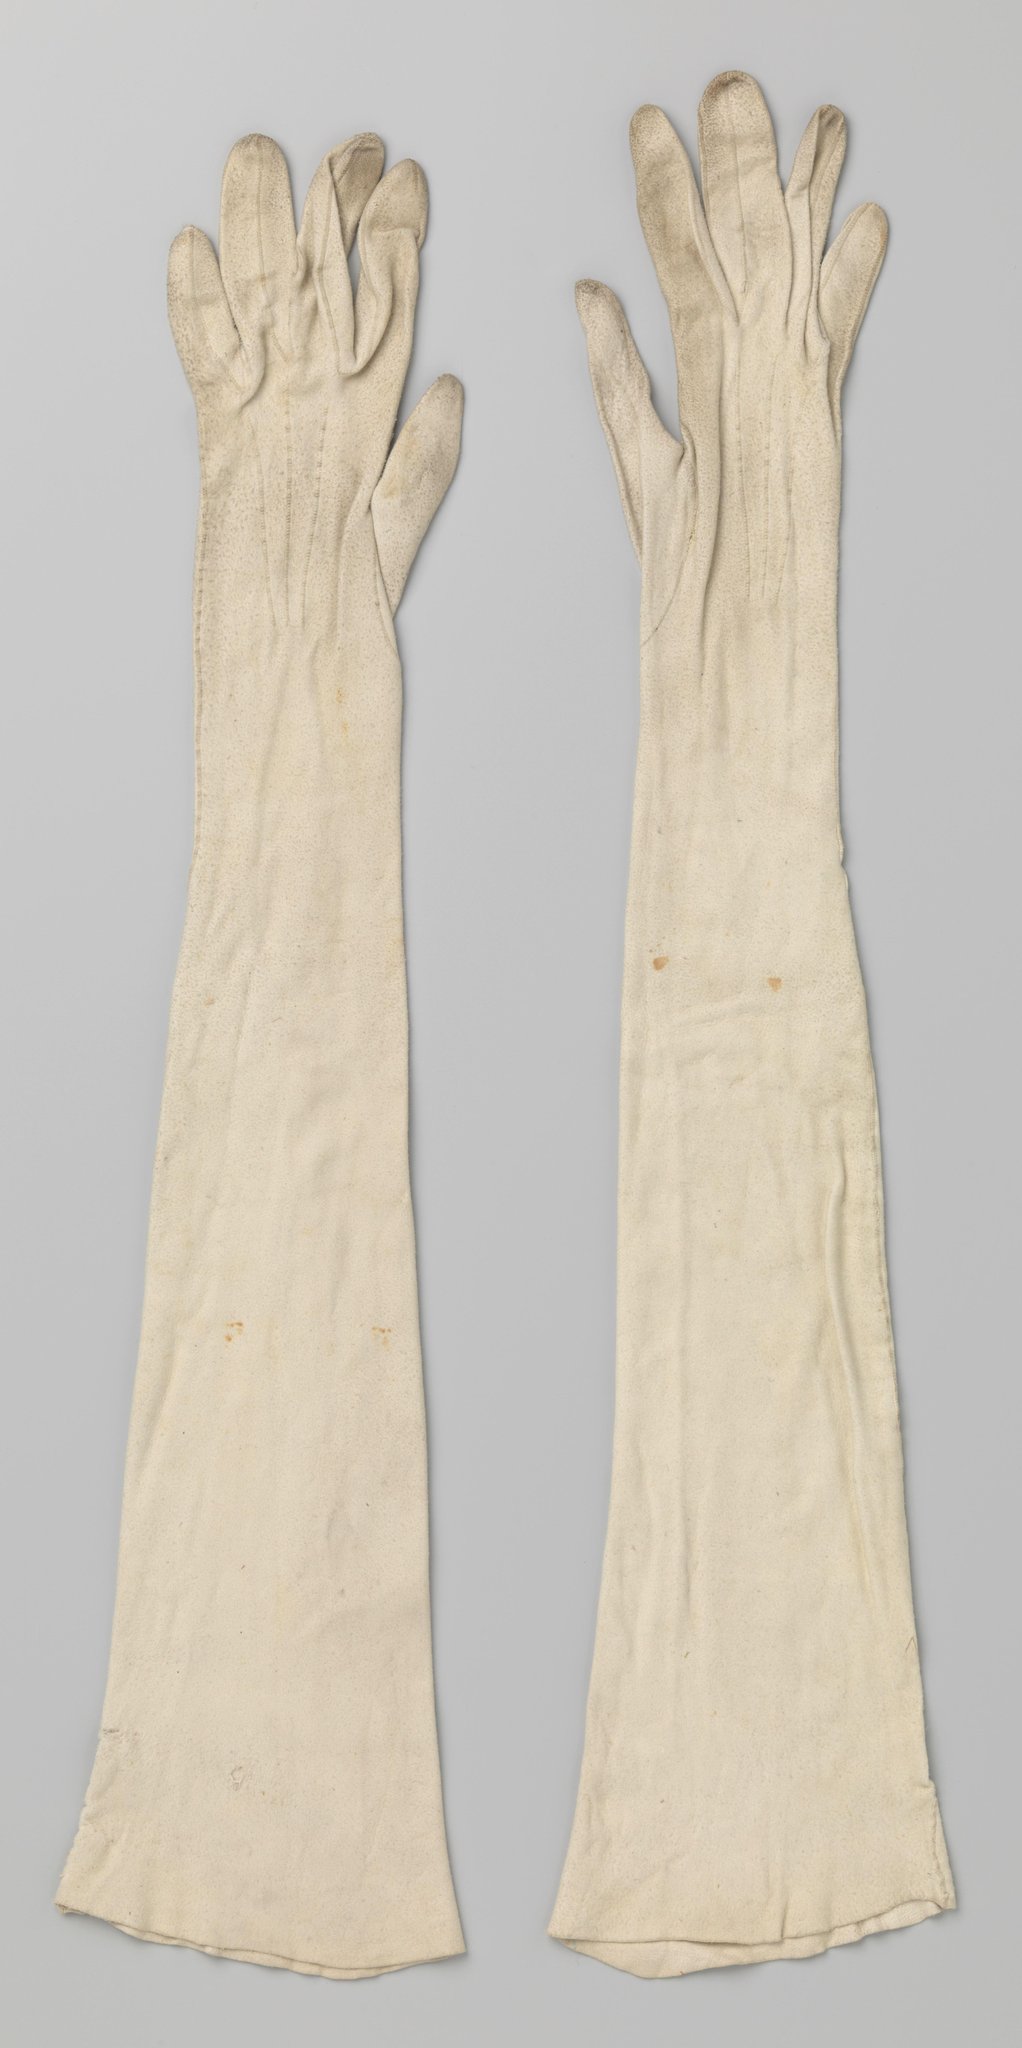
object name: clothing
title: Handschoen van wit zeemleer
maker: Anonymous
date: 1915-1925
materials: leather, mother of pearl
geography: france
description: Rechterhandschoen van wit zeemleer. Op de rug drie uitstralende koorden. Aan de binnenzijde een split met drie parelmoeren knopen. Extra lang model.